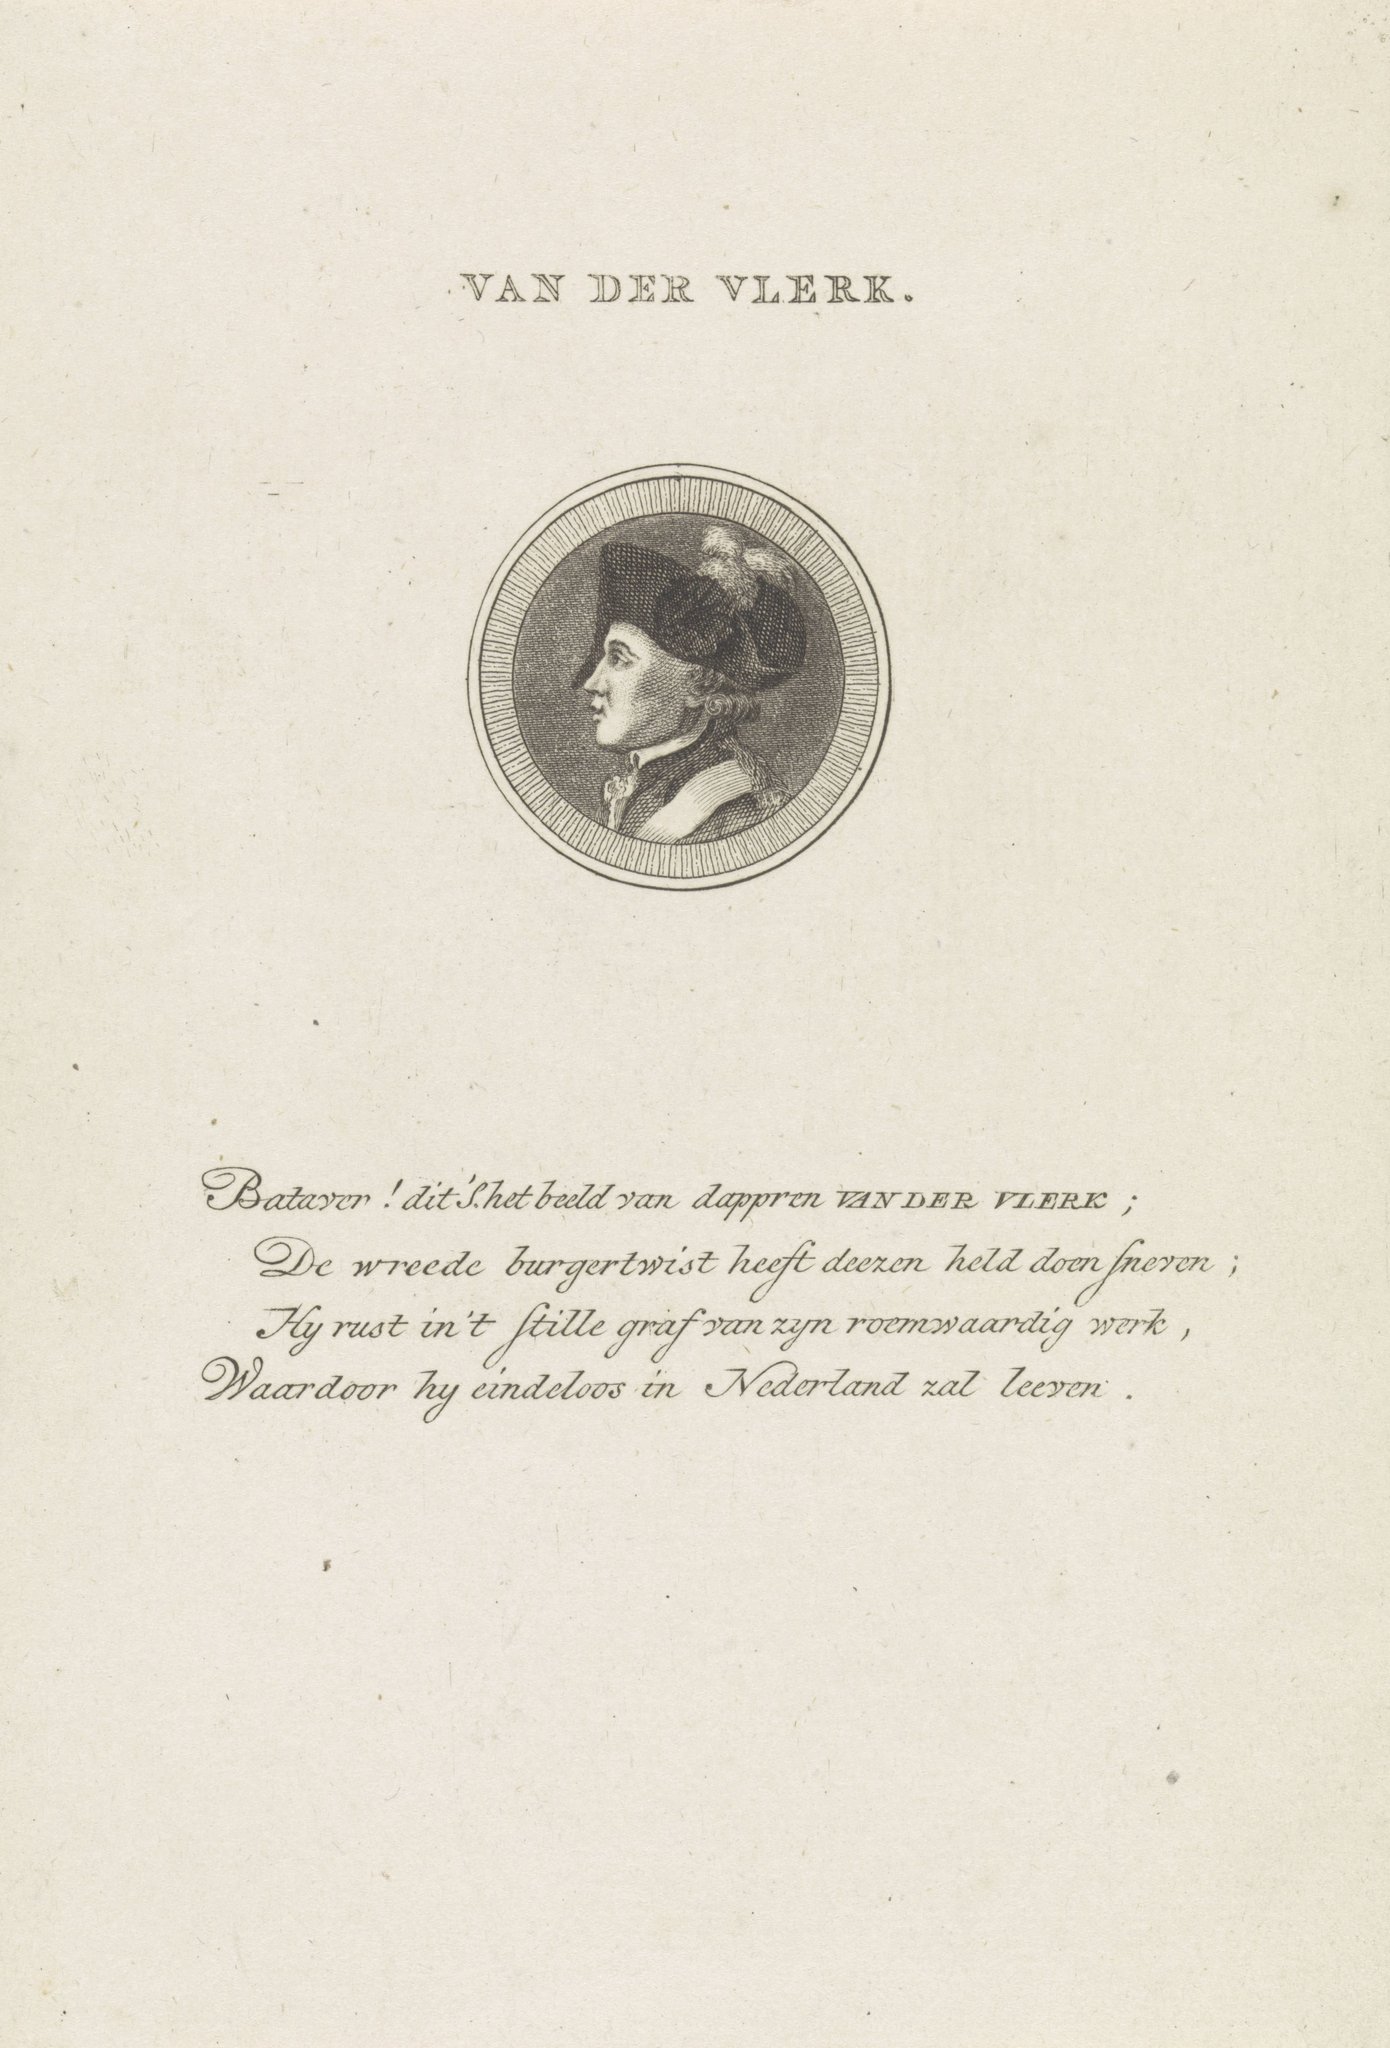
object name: print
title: Portretten van patriotten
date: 1787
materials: paper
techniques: engraving, etching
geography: amsterdam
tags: utrecht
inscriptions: collector's mark: Lugt 2228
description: Jacobus Wijsman heeft sommige platen van de serie patriottenportretten van Abraham Jacobsz. Hulk aangepast en hergebruikt in zijn eigen serie patriottenportretten. Prent maakt deel uit van een serie, die in drie afleveringen werd uitgegeven onder de titel: Verzameling van Afbeeldingen van Nederlandsche Mannen, beroemd geworden, wegens hunne Moed en Burgerliefde in de jongstledene Beroerten. 1794-1795. Zie Atlas van Stolk.